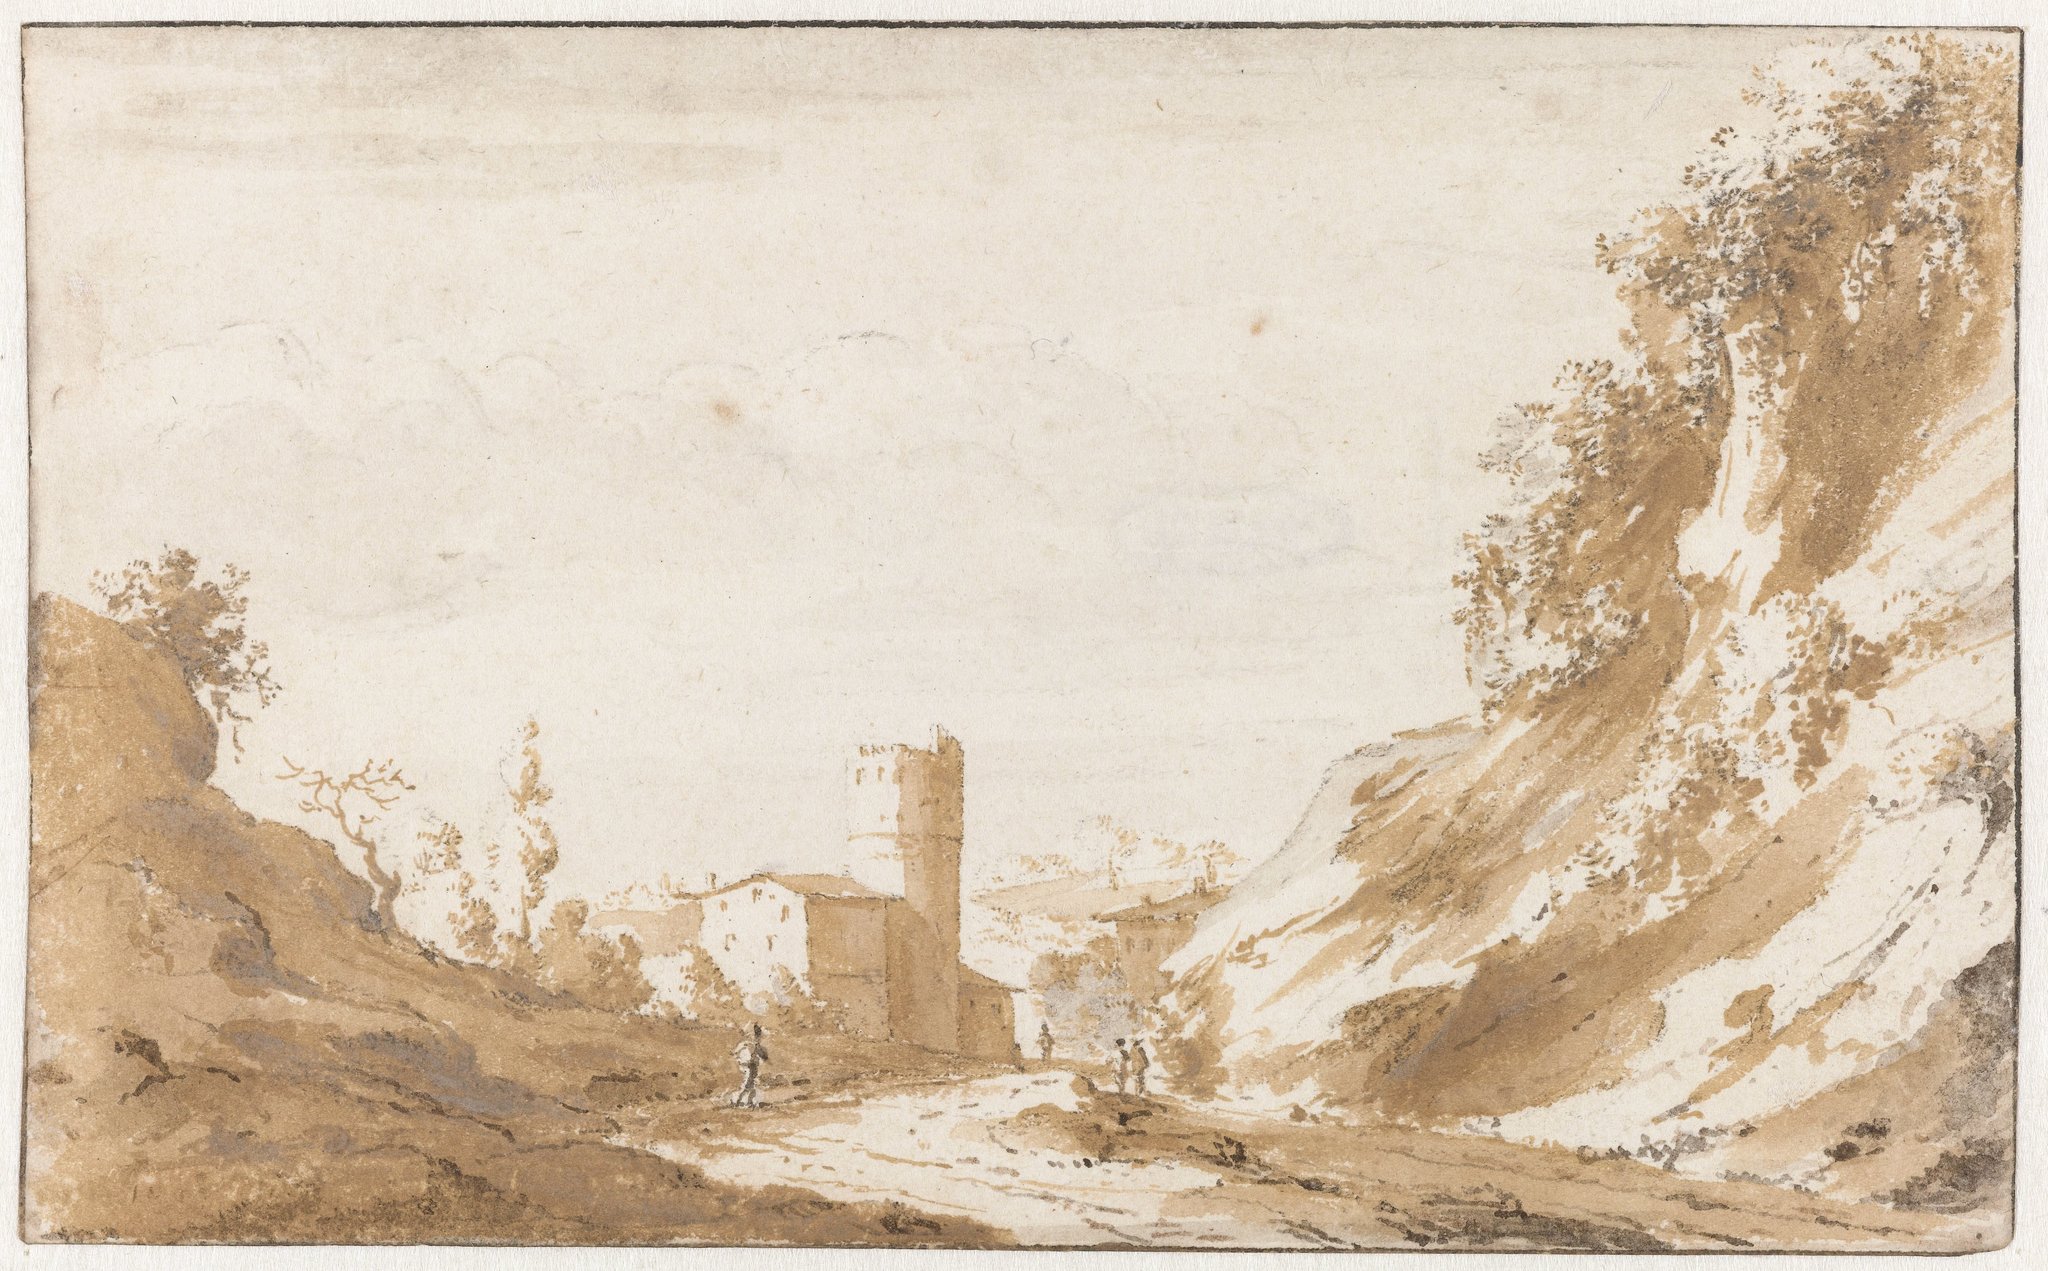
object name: drawing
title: Weg door heuvelachtig landschap buiten Brussel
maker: jan de bisschop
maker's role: draughtsman, print maker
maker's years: 1628-1671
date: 1648-1671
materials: chalk, paper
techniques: brush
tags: low hill country, brussels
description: Weg tussen heuvels waarop mensen lopen, in het midden staat een gebouw.